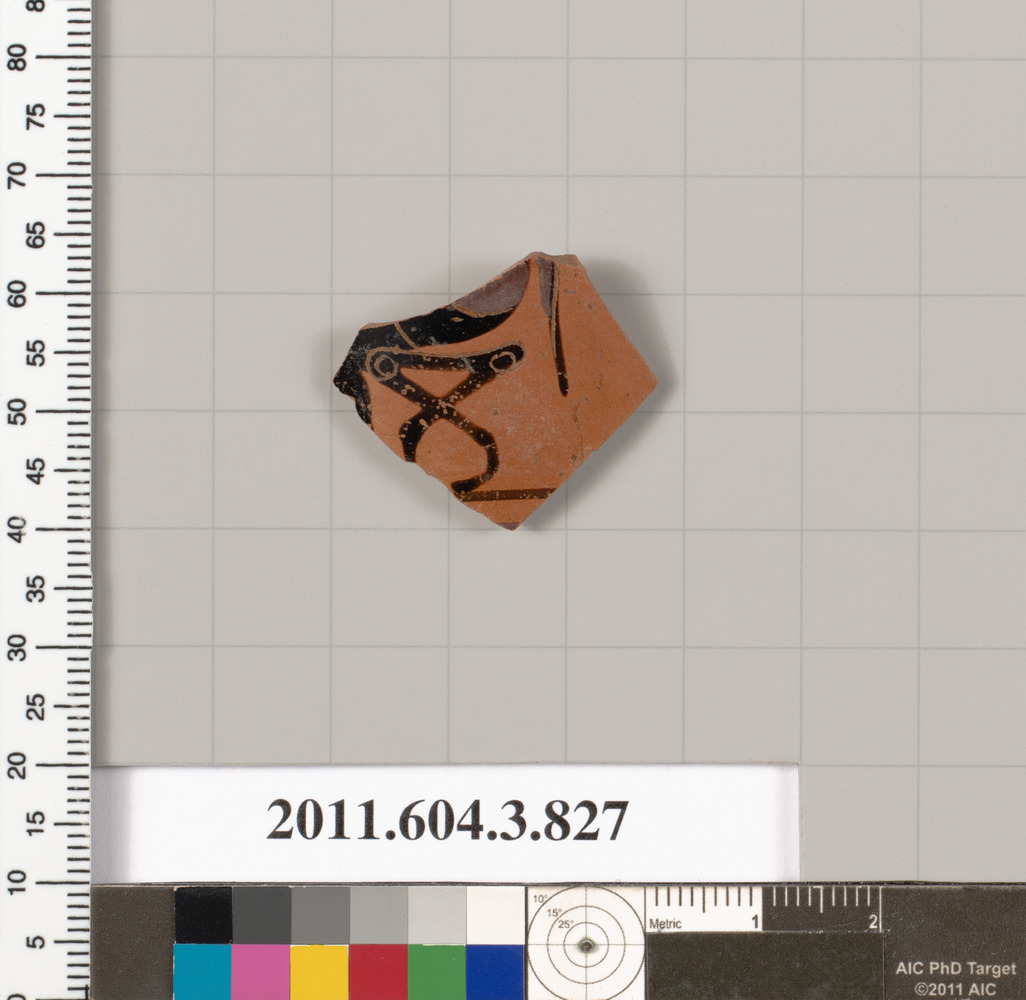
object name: lekythos fragment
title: Terracotta fragment of a lekythos (oil flask)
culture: greek, attic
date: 534-501 BCE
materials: terracotta